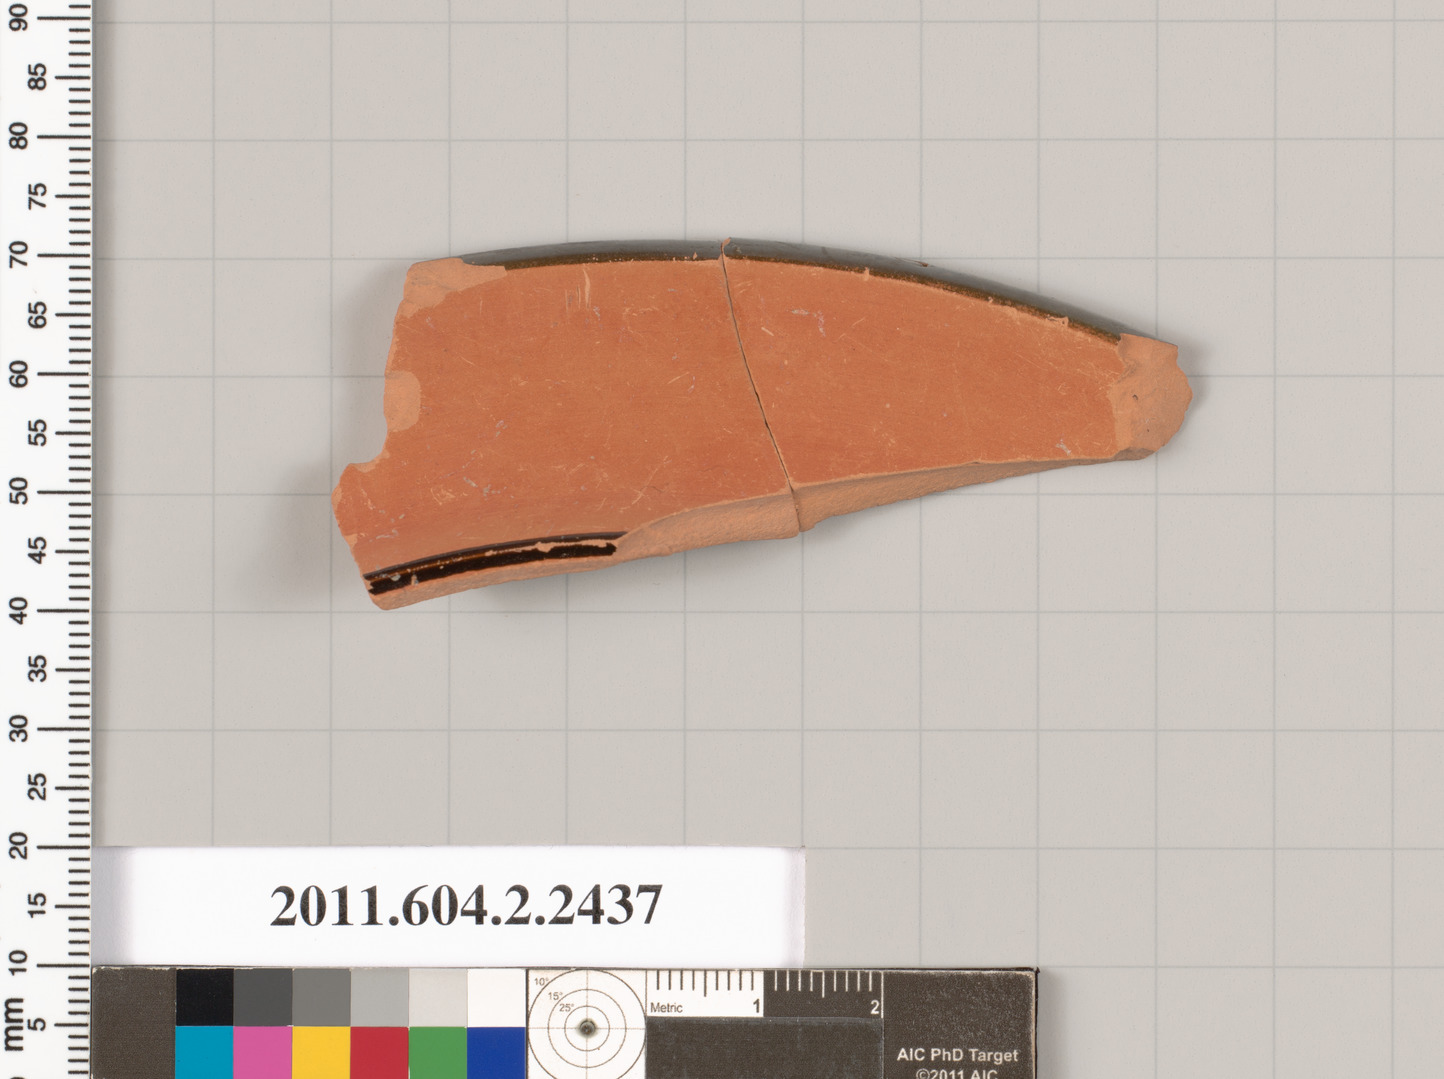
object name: plate fragment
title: Terracotta rim fragment from a plate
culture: greek, attic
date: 520-500 BCE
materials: terracotta